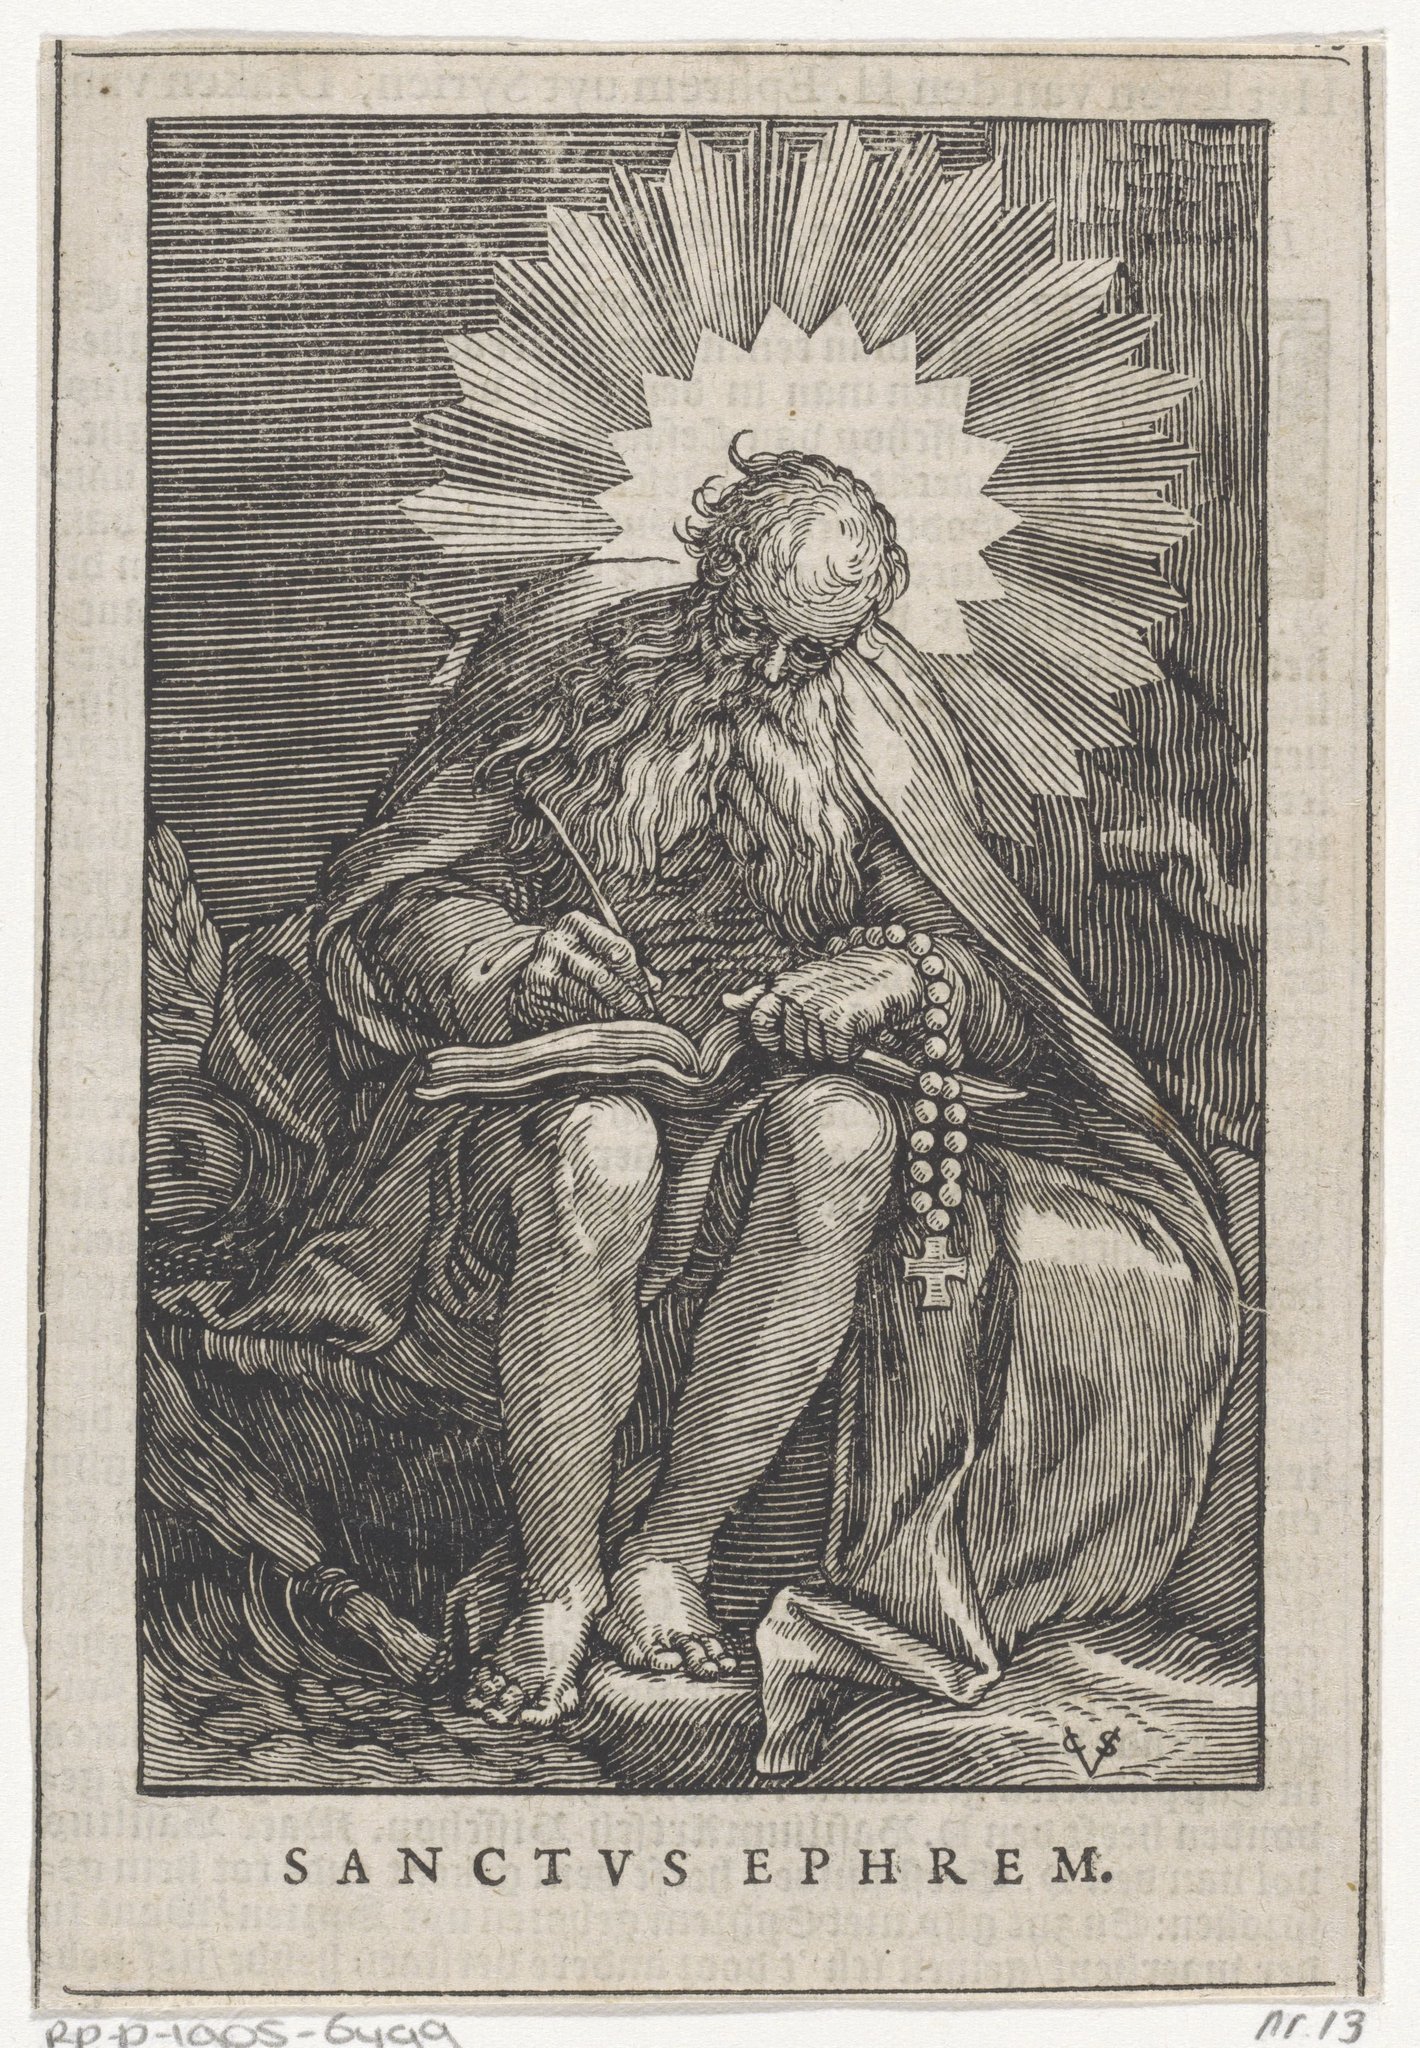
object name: book illustration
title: Sanctus Ephrem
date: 1644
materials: paper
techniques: letterpress printing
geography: amsterdam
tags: saints, anchorite, hermit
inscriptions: collector's mark: Lugt 2228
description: Prent uit: Rosweyde, Heribert. 'tBosch der eremyten ende eremitinnen, van Aegypten ende Palestinen. Amsterdam: Pieter Jacobsz. Paets, 1644.